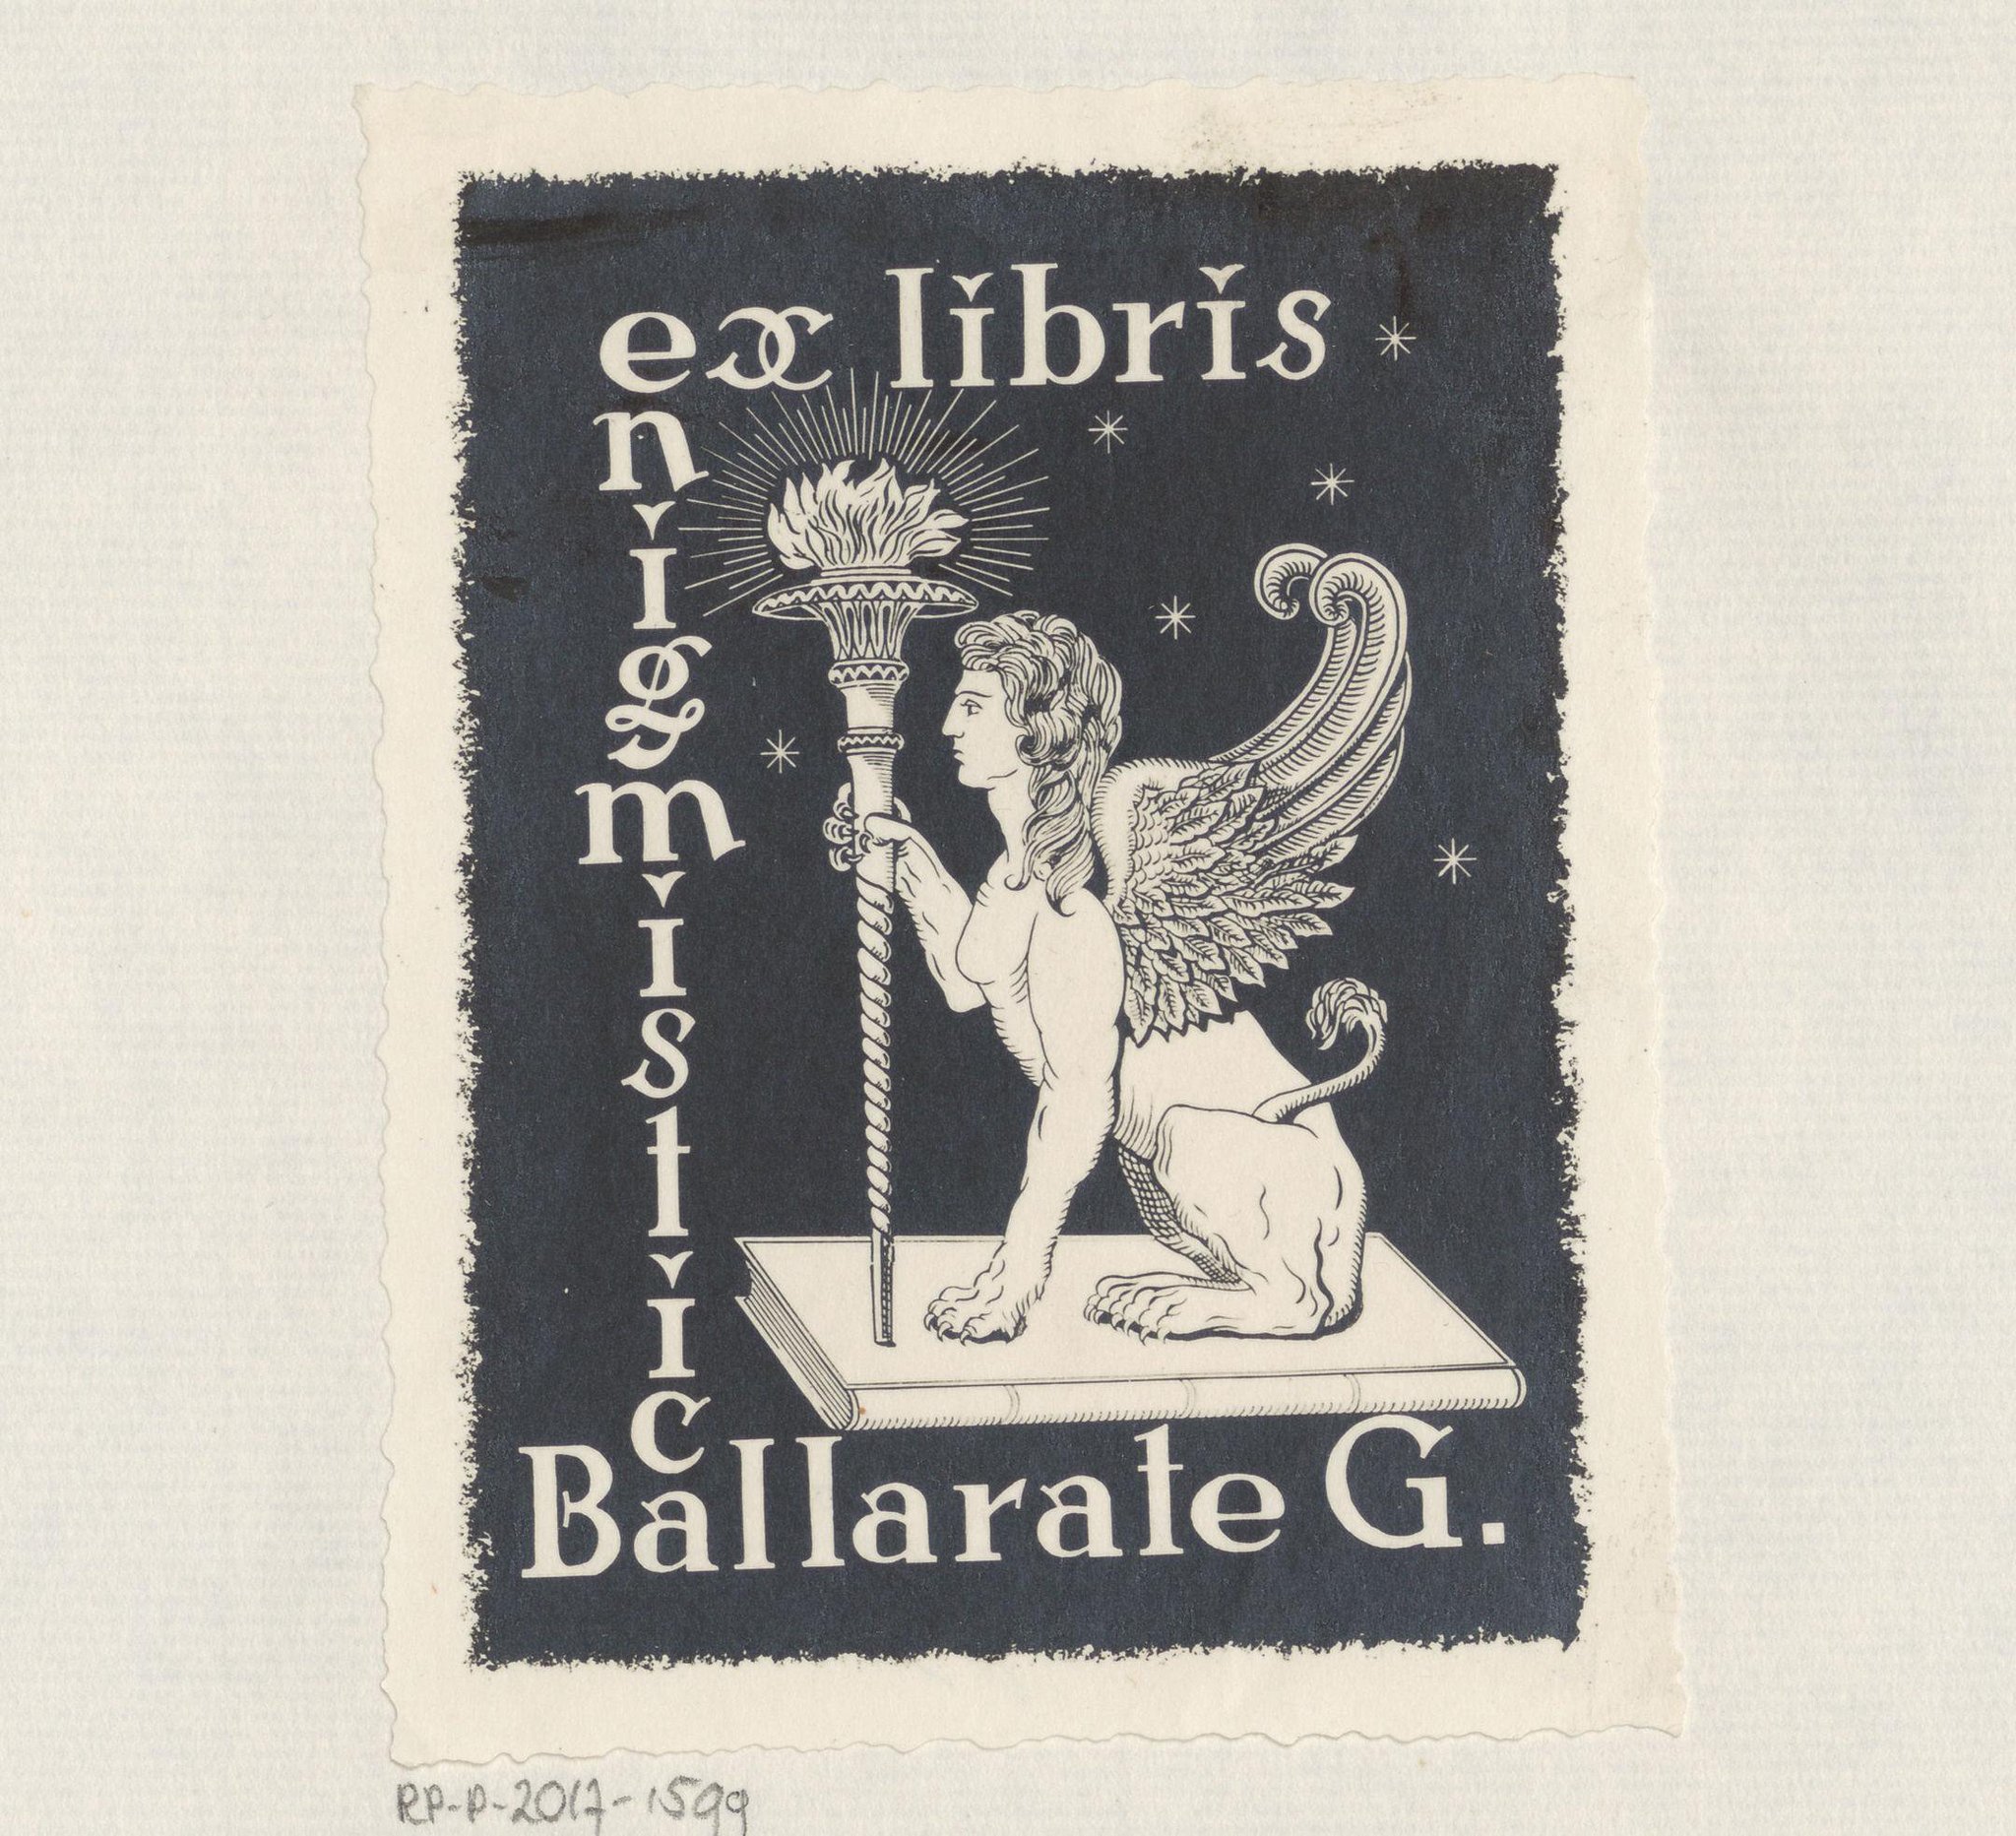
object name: bookplate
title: Ex libris van G. Ballarate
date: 1930-1960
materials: paper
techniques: printing block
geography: italy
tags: print maker, gemma ballarate fiocchi, torch, sphinx (lion/woman); 'sfinge' (ripa), book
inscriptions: number: ‘19-’, signature: ‘G Ballarate’